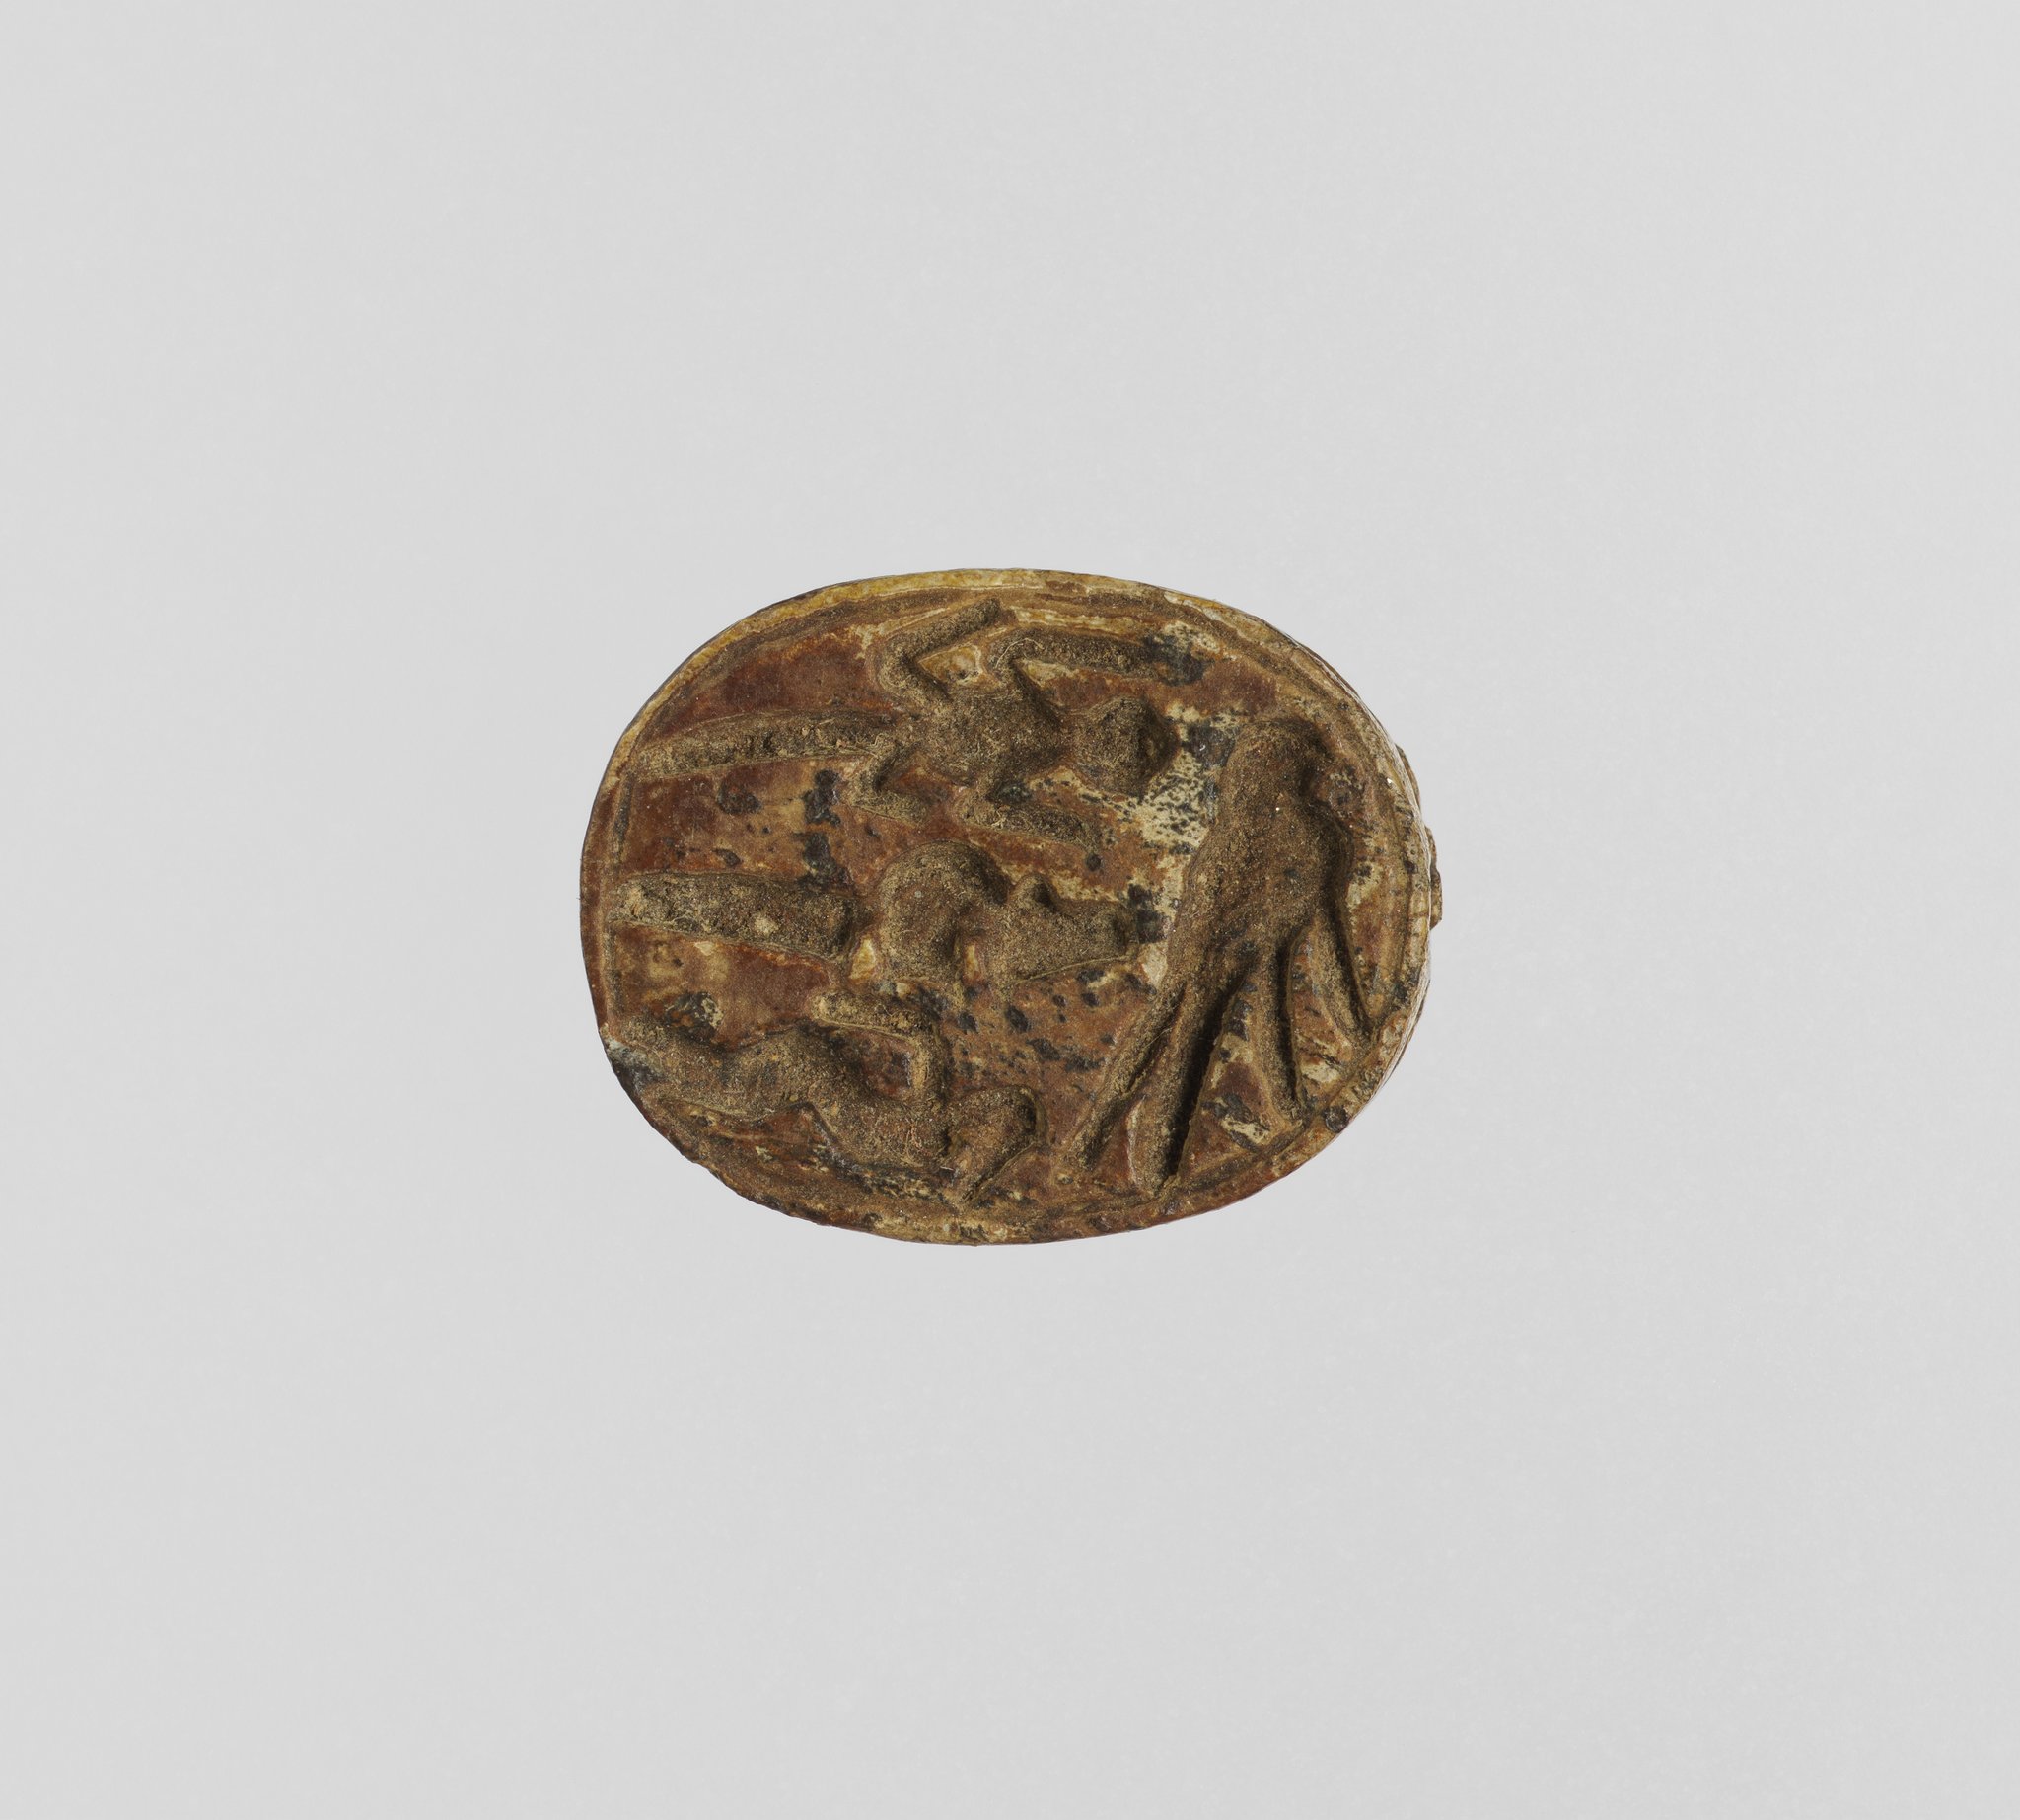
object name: scarab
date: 1295-1070 BCE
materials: faience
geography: egypt